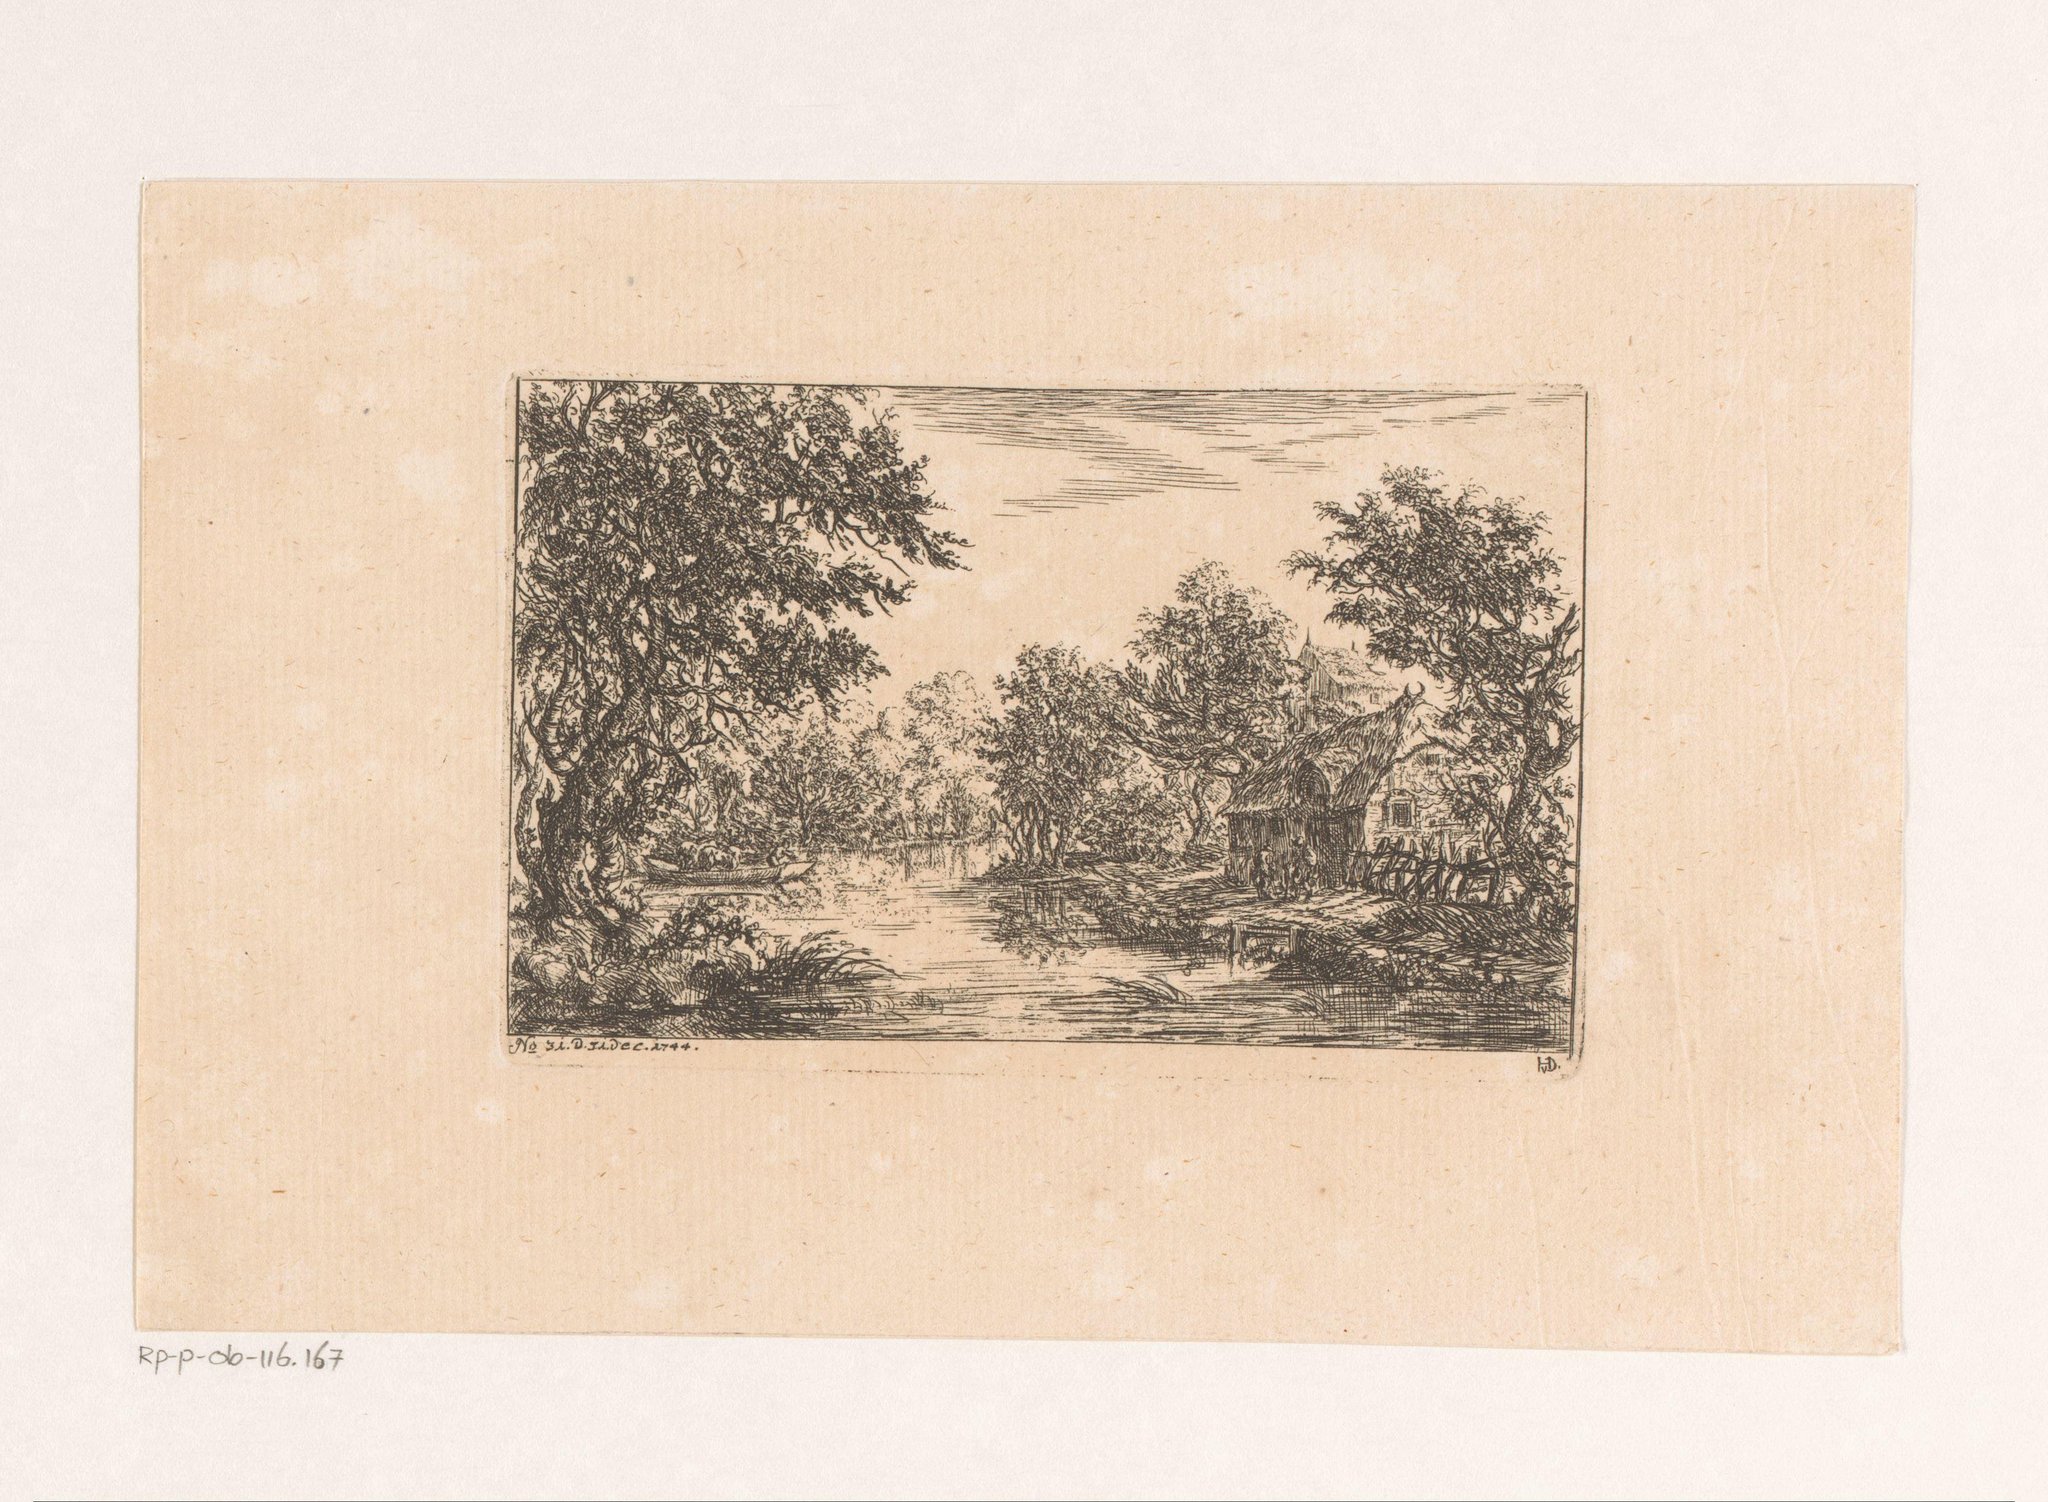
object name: print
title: Huis aan het water in een boslandschap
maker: christian ludwig von hagedorn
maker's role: painter, print maker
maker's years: 1712-1780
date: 1744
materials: paper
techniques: etching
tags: river (+ landscape with figures, staffage)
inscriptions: collector's mark: Lugt 240